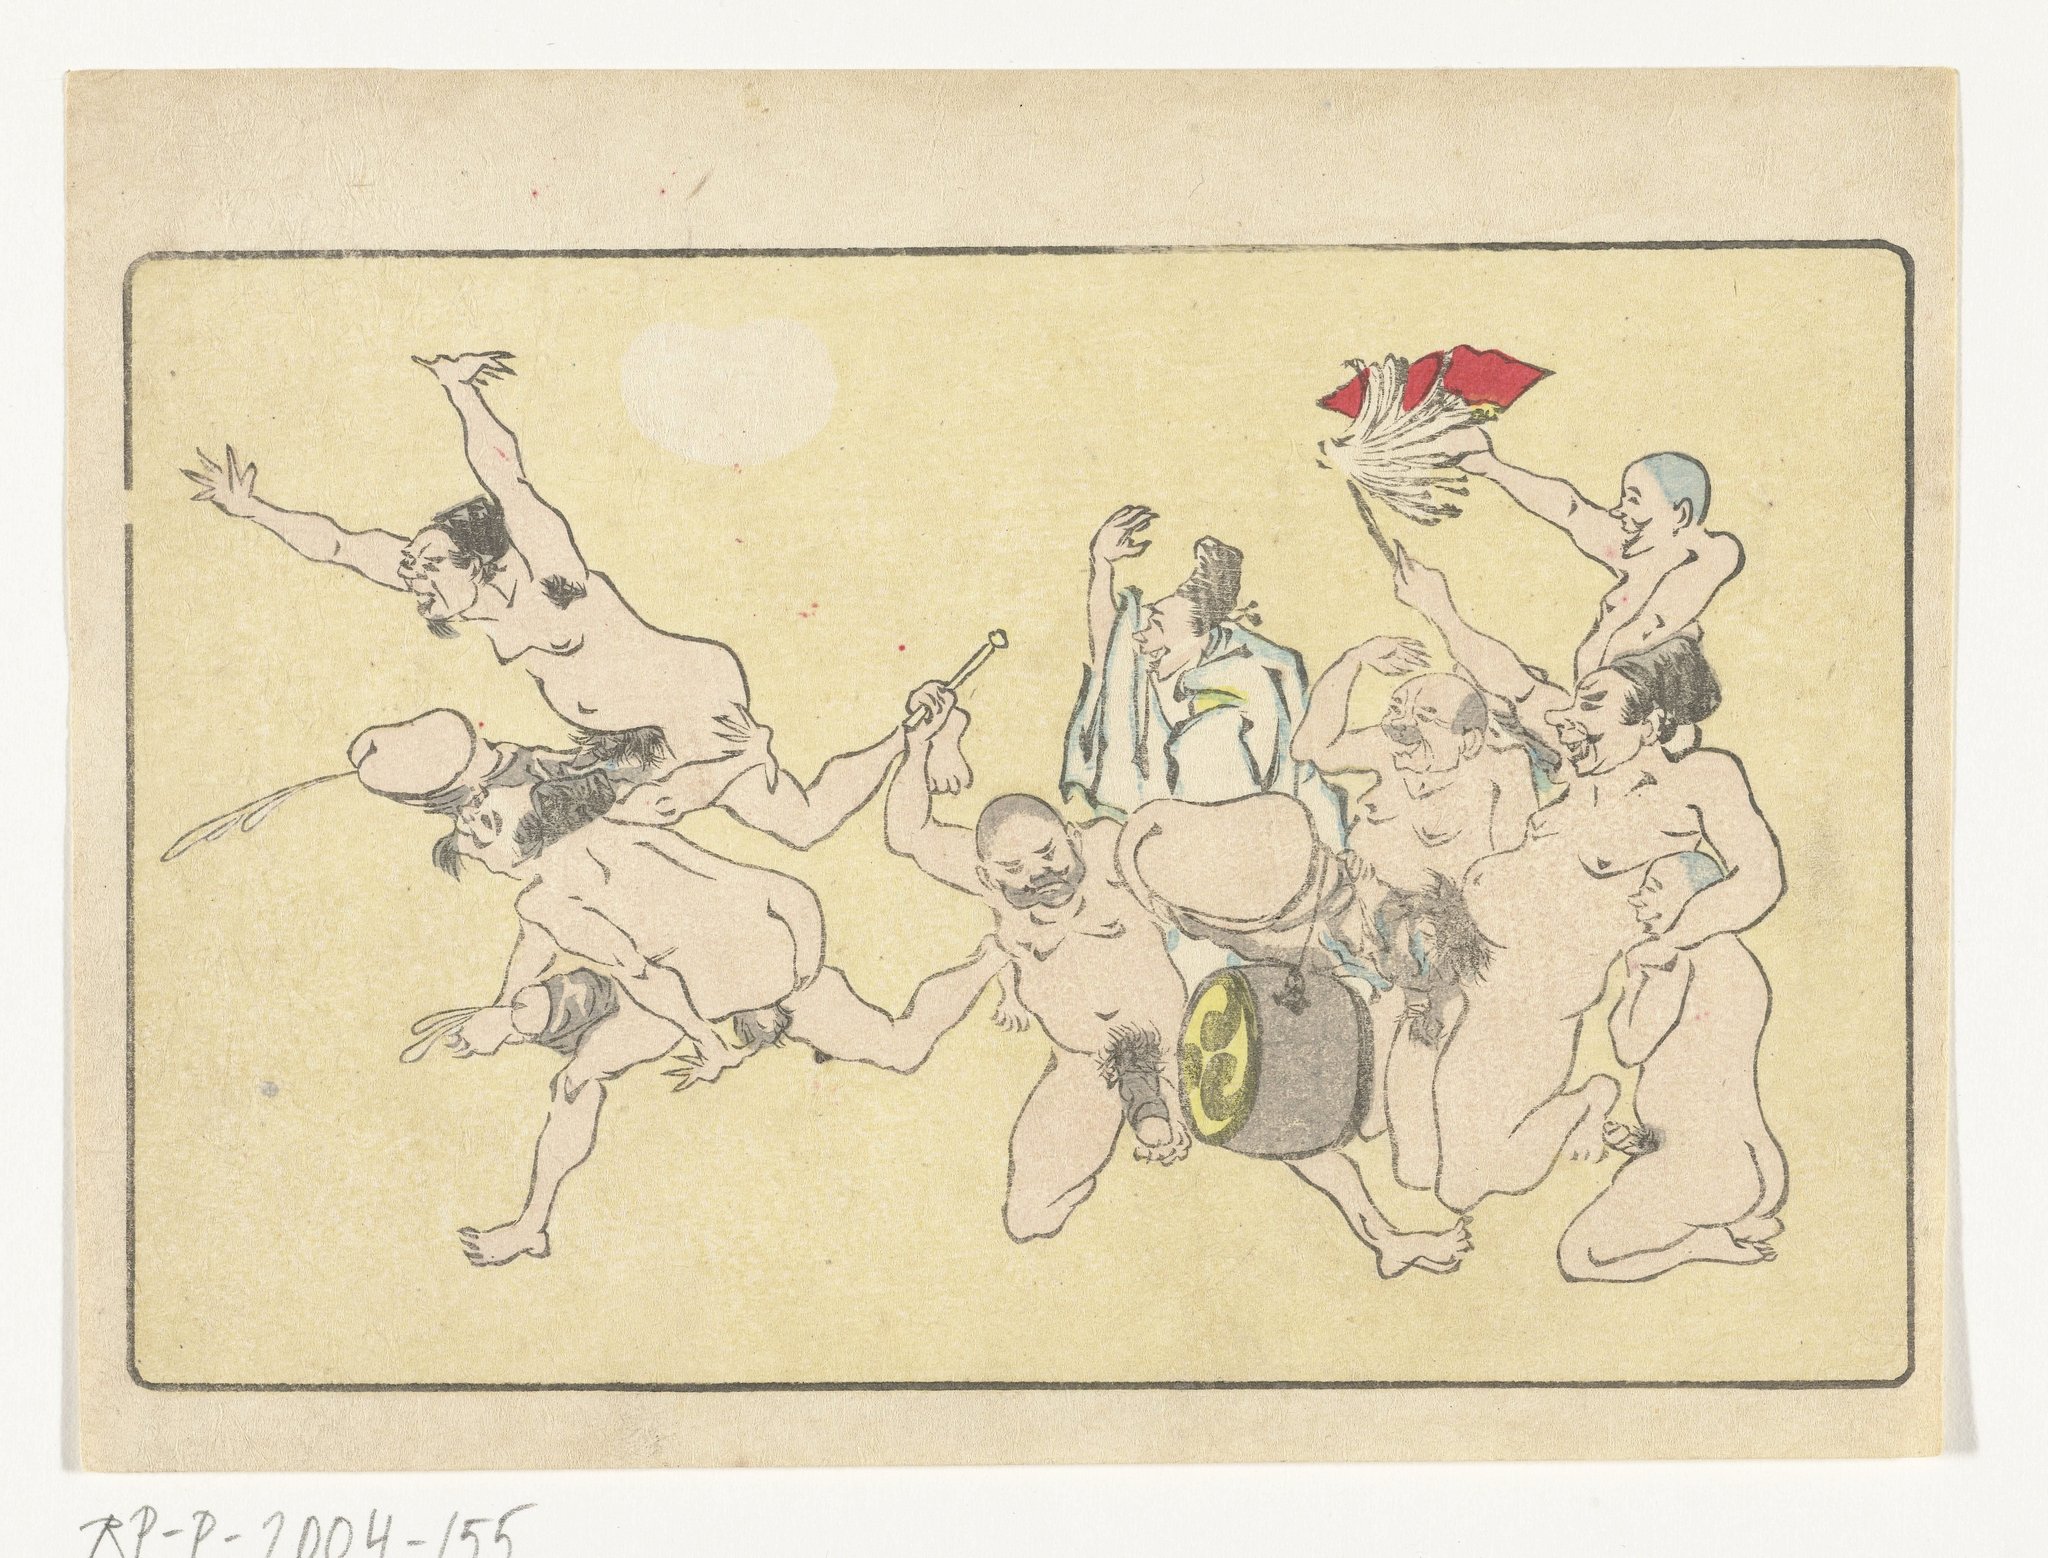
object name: print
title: De grote staart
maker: kawanabe kyôsai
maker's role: draughtsman, print maker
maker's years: 1831-1889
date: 1870-1880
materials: paper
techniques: woodcut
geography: japan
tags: percussion instruments, running, man (showing himself) undressed, quasi-nude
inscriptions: collector's mark: Lugt 2760, collector's mark: Lugt 2228